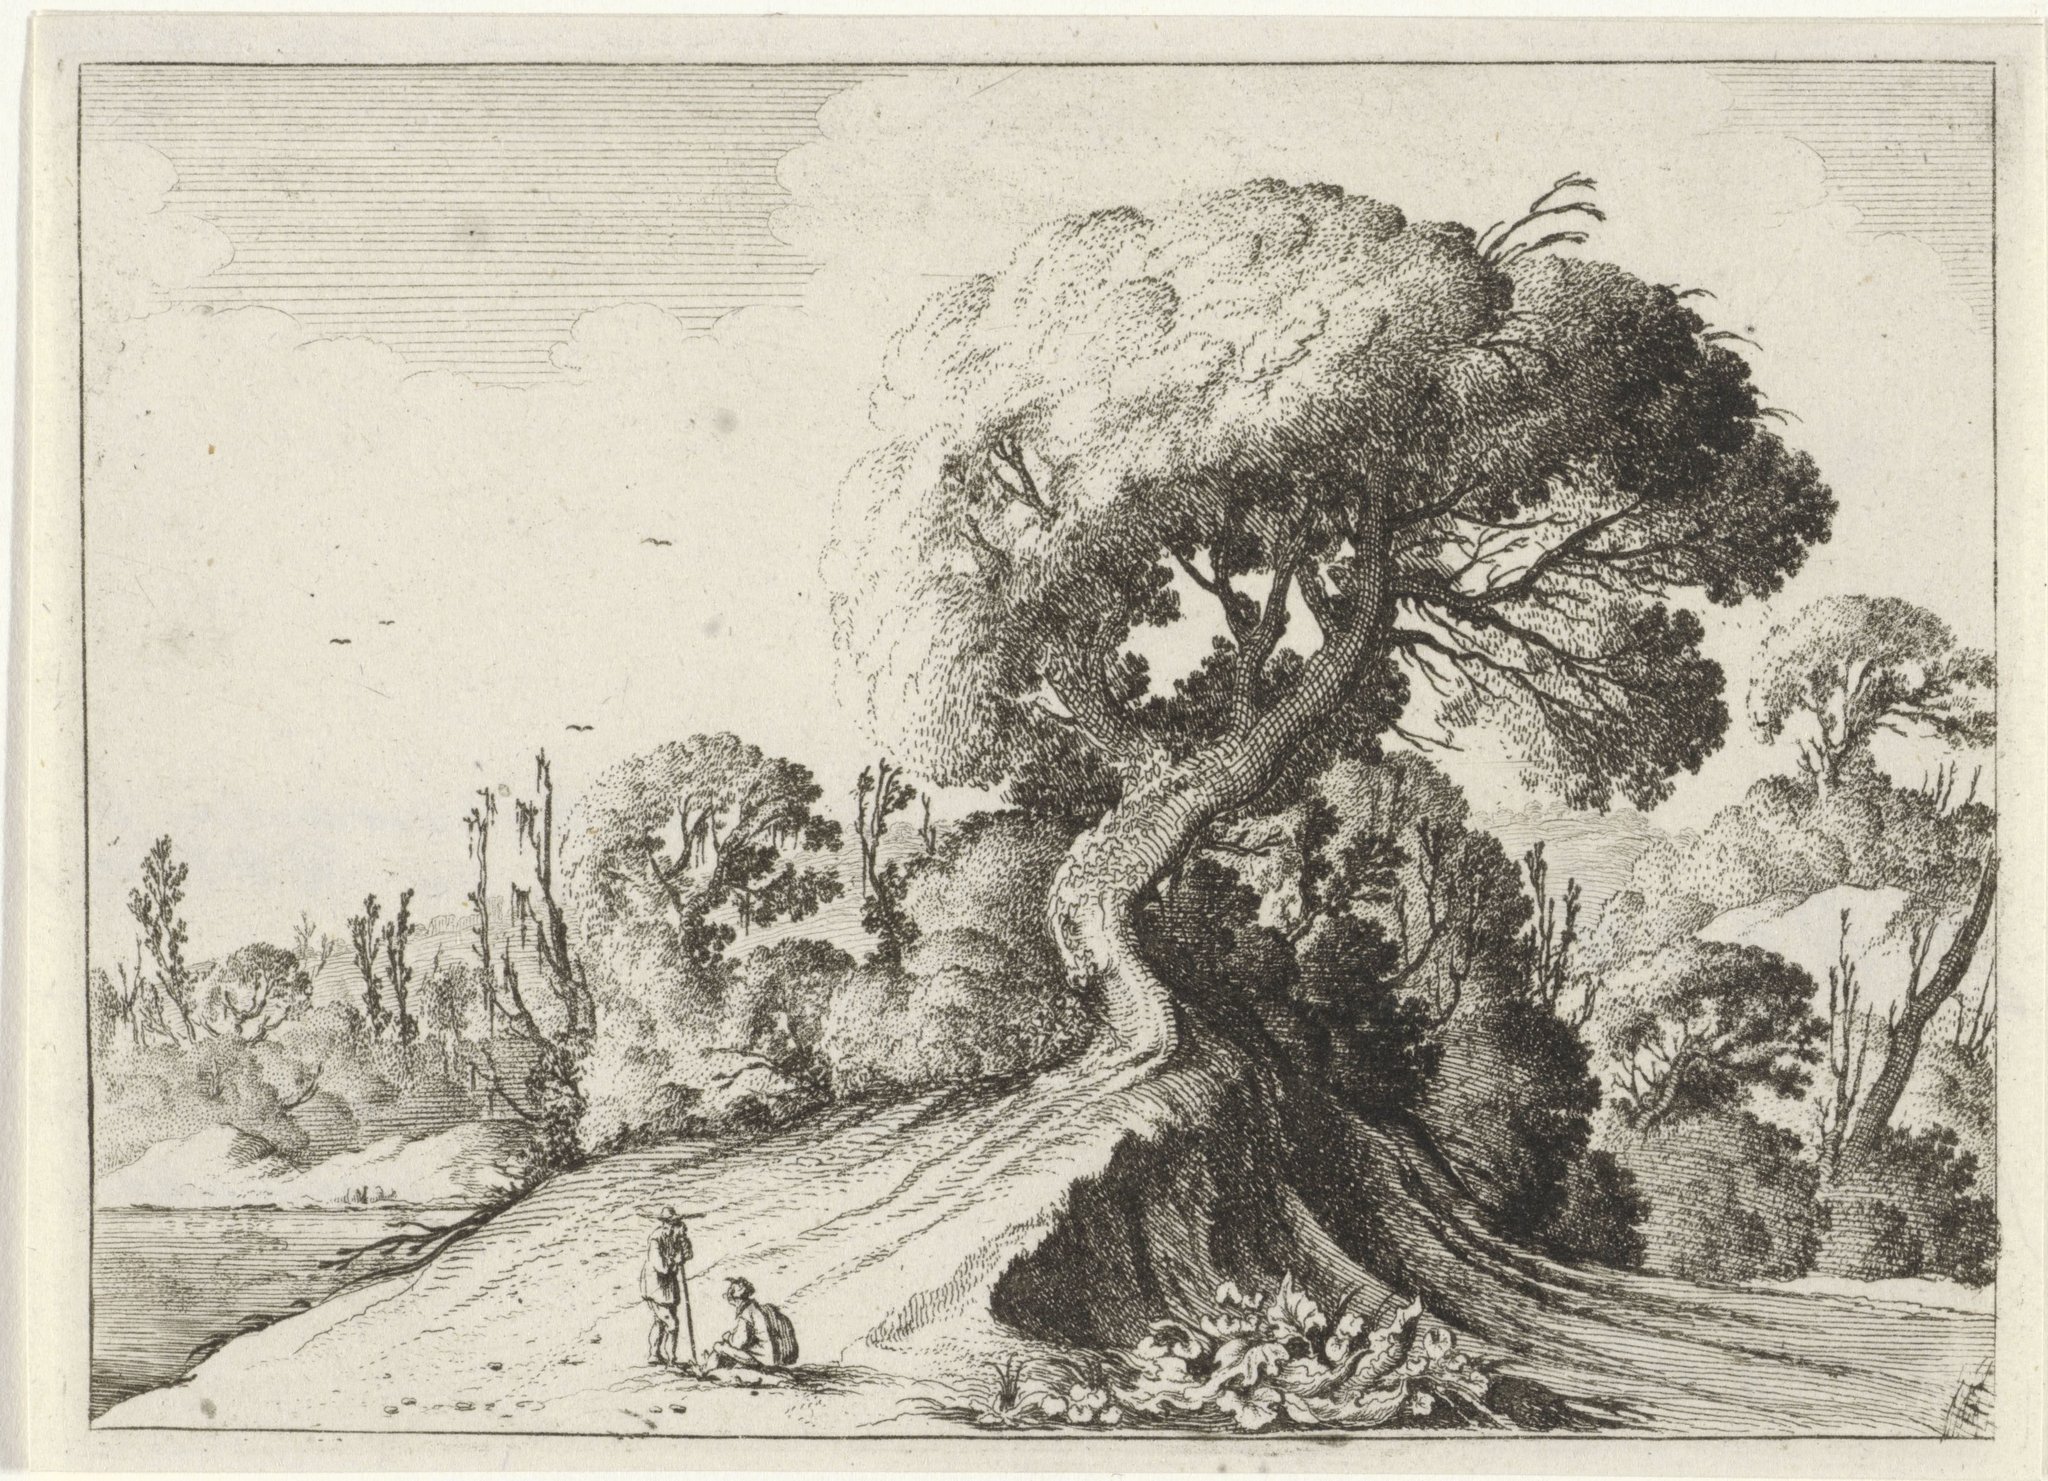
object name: print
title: Twee mannen voor een grote boom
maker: gillis van scheyndel (i)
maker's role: draughtsman, print maker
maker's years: 1595-1660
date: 1631-1653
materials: paper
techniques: engraving, etching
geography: netherlands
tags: trees, (traveller) resting in the open air, forest, wood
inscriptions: collector's mark: Lugt 2228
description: Op een pad voor een grote boom bevinden zich twee mannen, de een zit en de ander leunt op zijn wandelstok. Op de achtergrond een bosrand. De prent maakt deel uit van een serie van zeven landschappen.